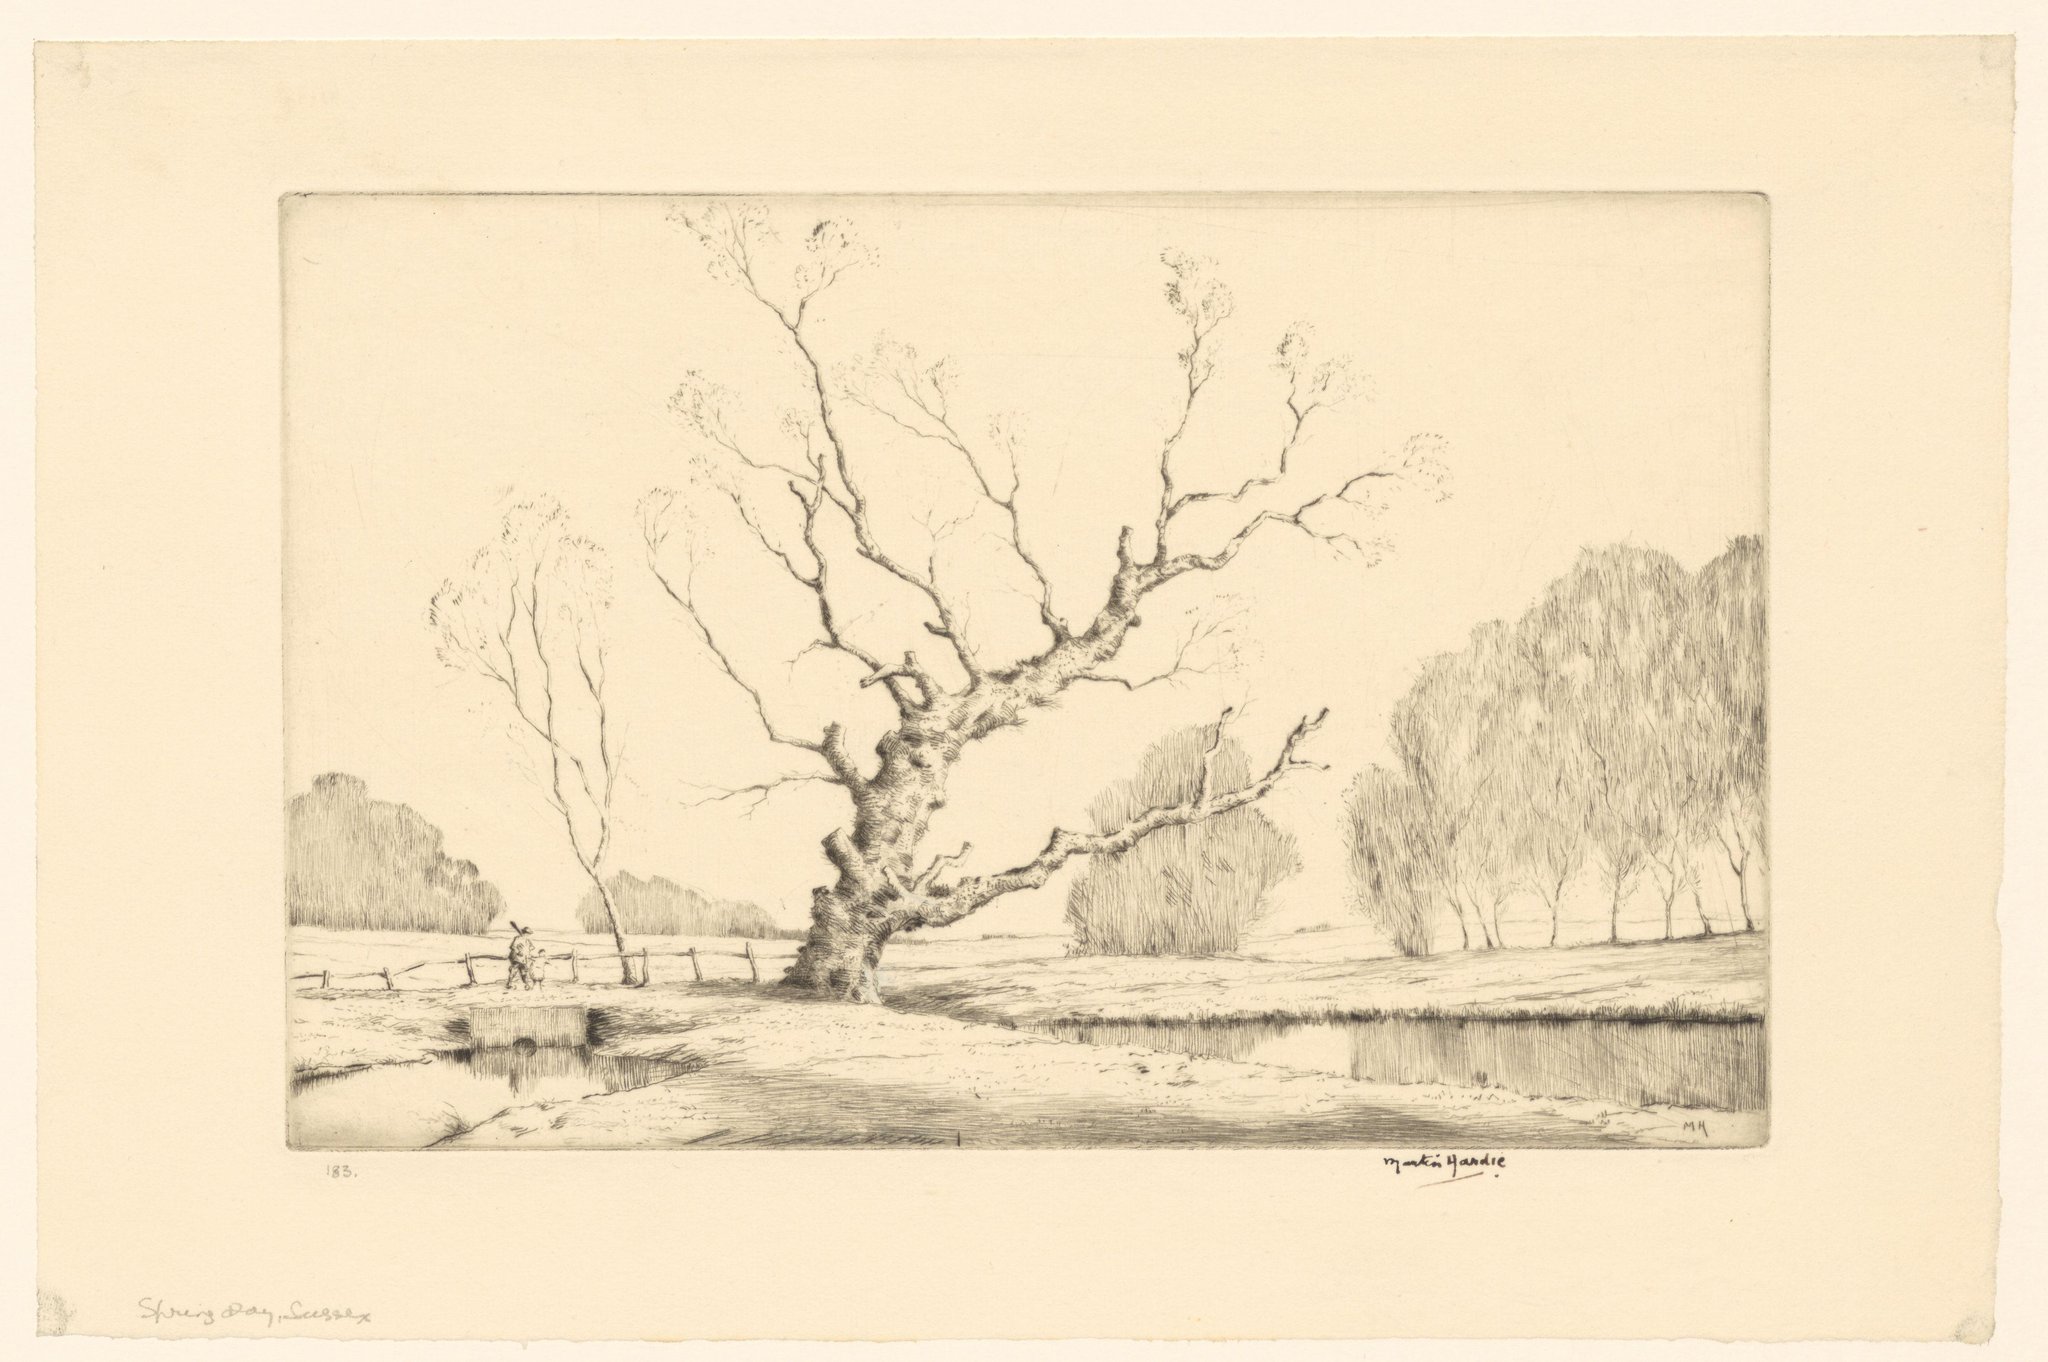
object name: print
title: Landschap met een grote boom in de knop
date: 1946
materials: paper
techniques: drypoint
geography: sussex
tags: trees, spring, 'ver'; 'primavera' (ripa)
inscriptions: collector's mark: Lugt 2760, collector's mark: Lugt 2228, annotation: ‘Martin Hardie’